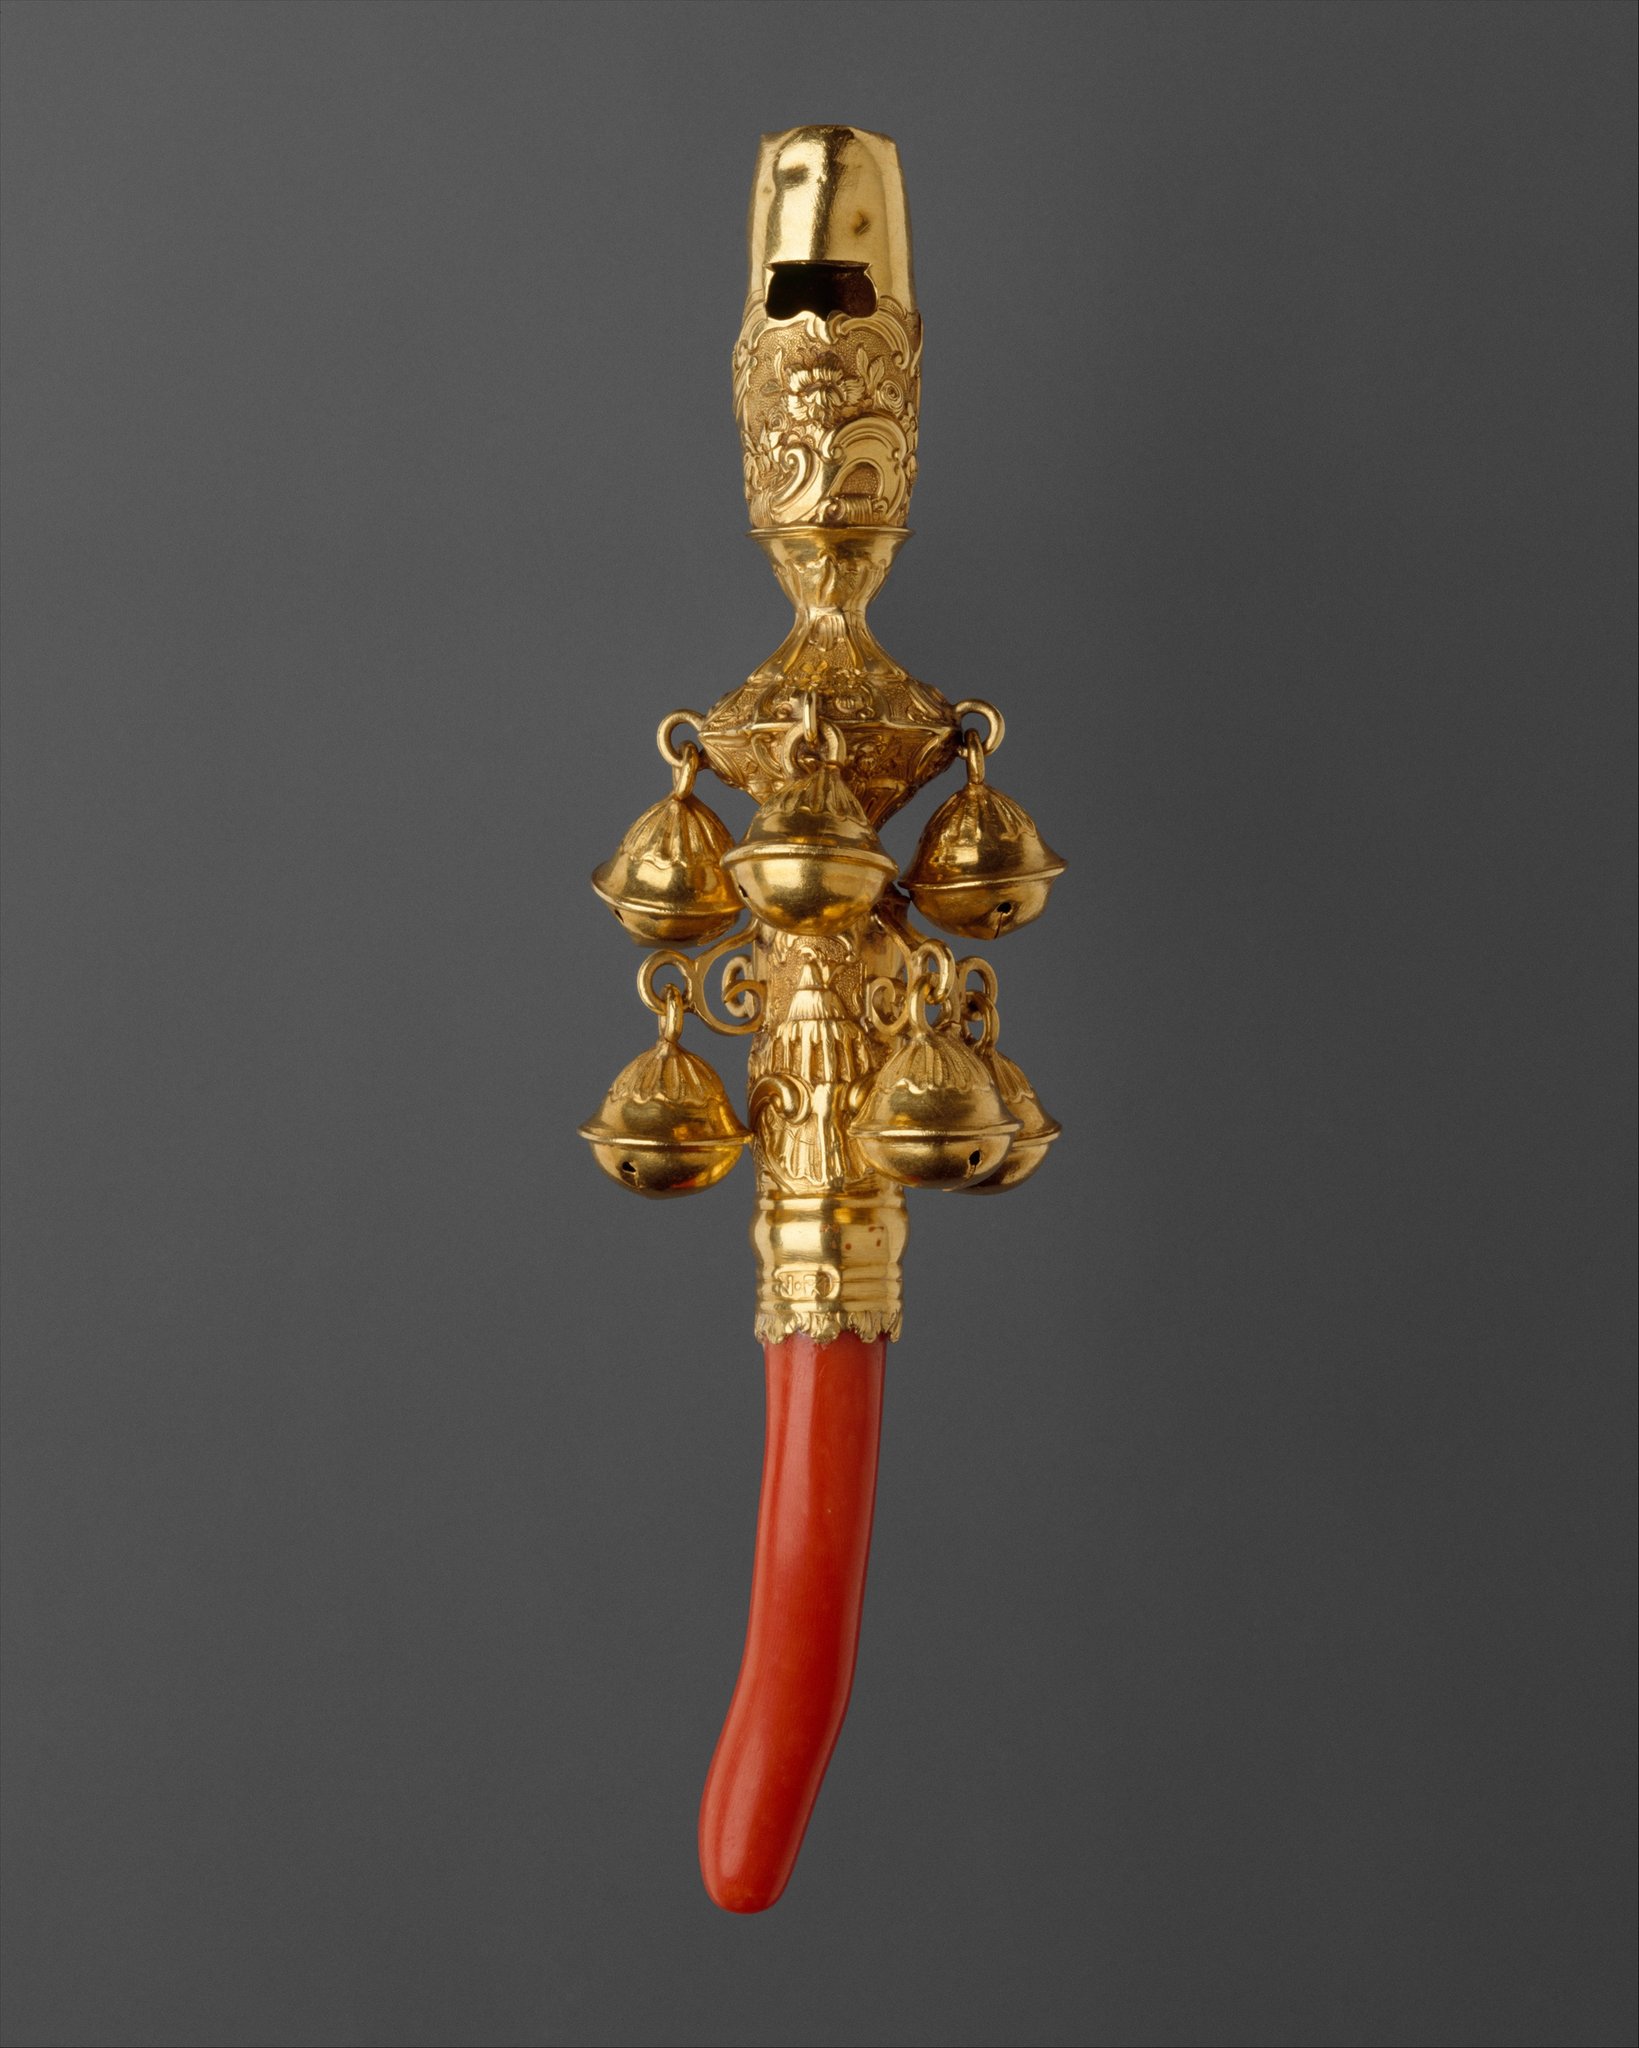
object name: rattle, whistle, and bell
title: Rattle, Whistle, and Bells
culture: american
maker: nicholas roosevelt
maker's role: maker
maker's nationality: american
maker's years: 1715-1769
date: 1755-1768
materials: coral, gold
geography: united states